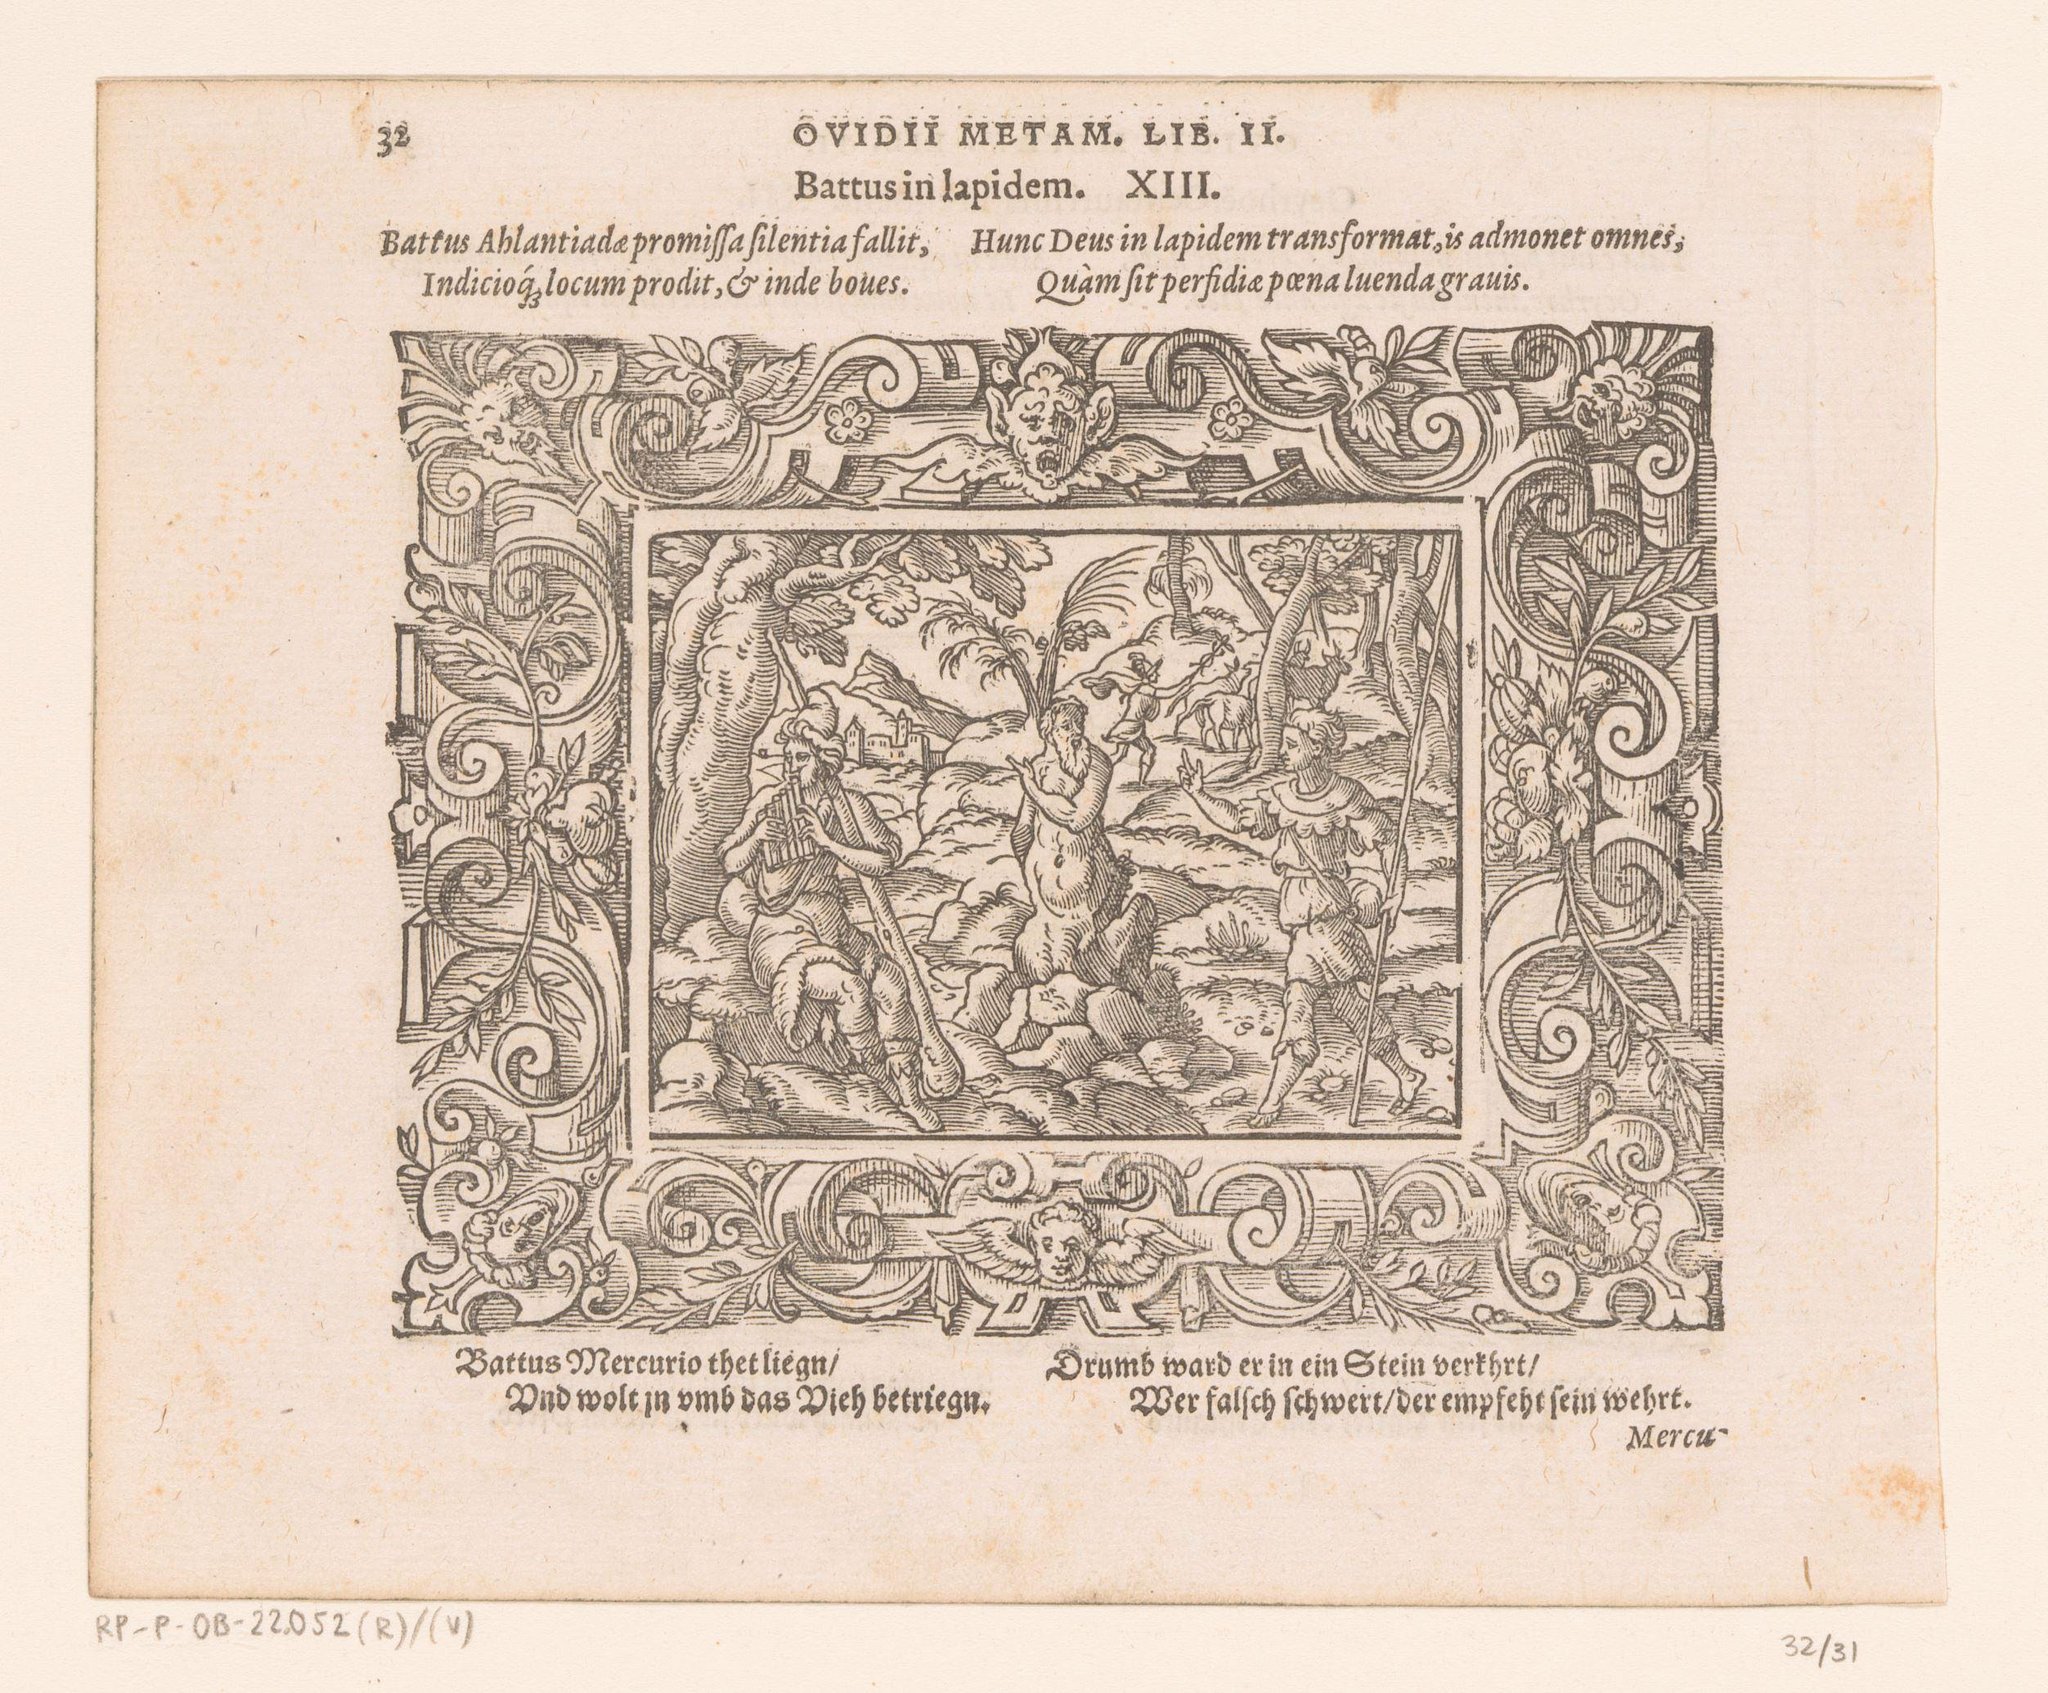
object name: print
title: Mercurius verandert Battus in een steen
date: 1569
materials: paper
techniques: letterpress printing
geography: nuremberg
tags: battus changed into a touchstone: for violating the promise to keep mercury's theft of apollo's cattle a secret, mercury turns battus, the shepherd, into a touchstone (ovid, metamorphoses ii 705), scrollwork, strapwork ~ ornament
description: Illustratie bij de Metamorfosen van Ovidius, afkomstig uit de publicatie: Posthius, Johannes. Tetrasticha in Ovidii metam. Frankfurt am Main: Georg Rab en Sigmund Feyerabend en erven Weigand Han, 1569. De voorstellingen en ornamentranden van deze boekillustraties zijn van twee aparte blokken gedrukt. Beide werden afzonderlijk van elkaar ook gebruikt voor andere publicaties, en de ornamentranden werden eveneens binnen deze publicatie meerdere keren gebruikt.